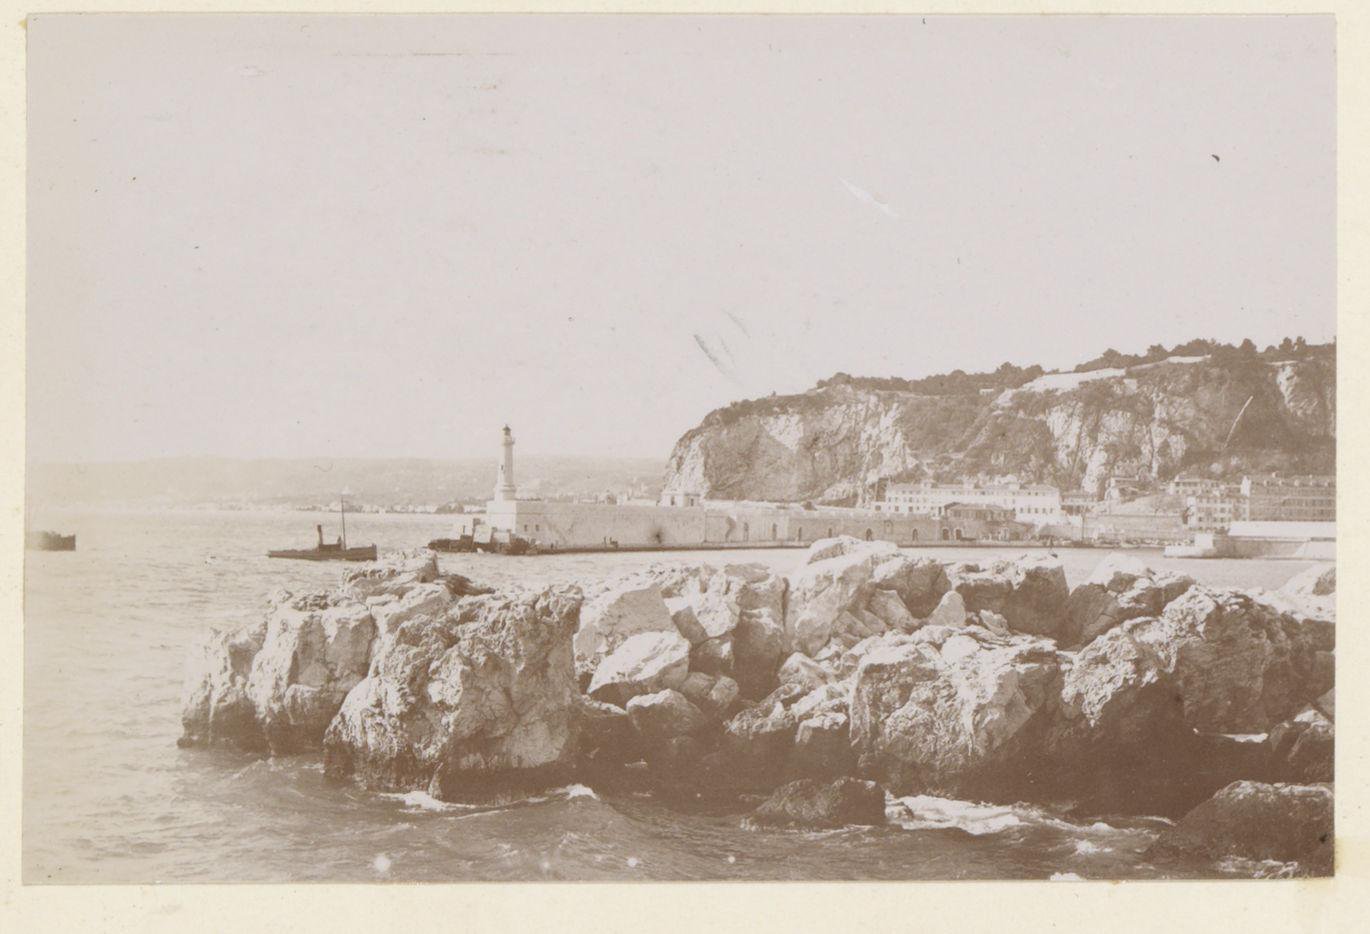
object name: photograph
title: Gezicht op een haveningang met vuurtoren, vermoedelijk aan de kust van Zuid-Frankrijk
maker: Anonymous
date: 1900-1910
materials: paper, photographic support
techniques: daylight paper print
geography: southern france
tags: lighthouse, lightship, coast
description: Onderdeel van Fotoalbum van een Franse amateurfotograaf met opnames van een familie, distilleerderij Delizy & Doistau Fils, het leger en bezienswaardigheden in Frankrijk.